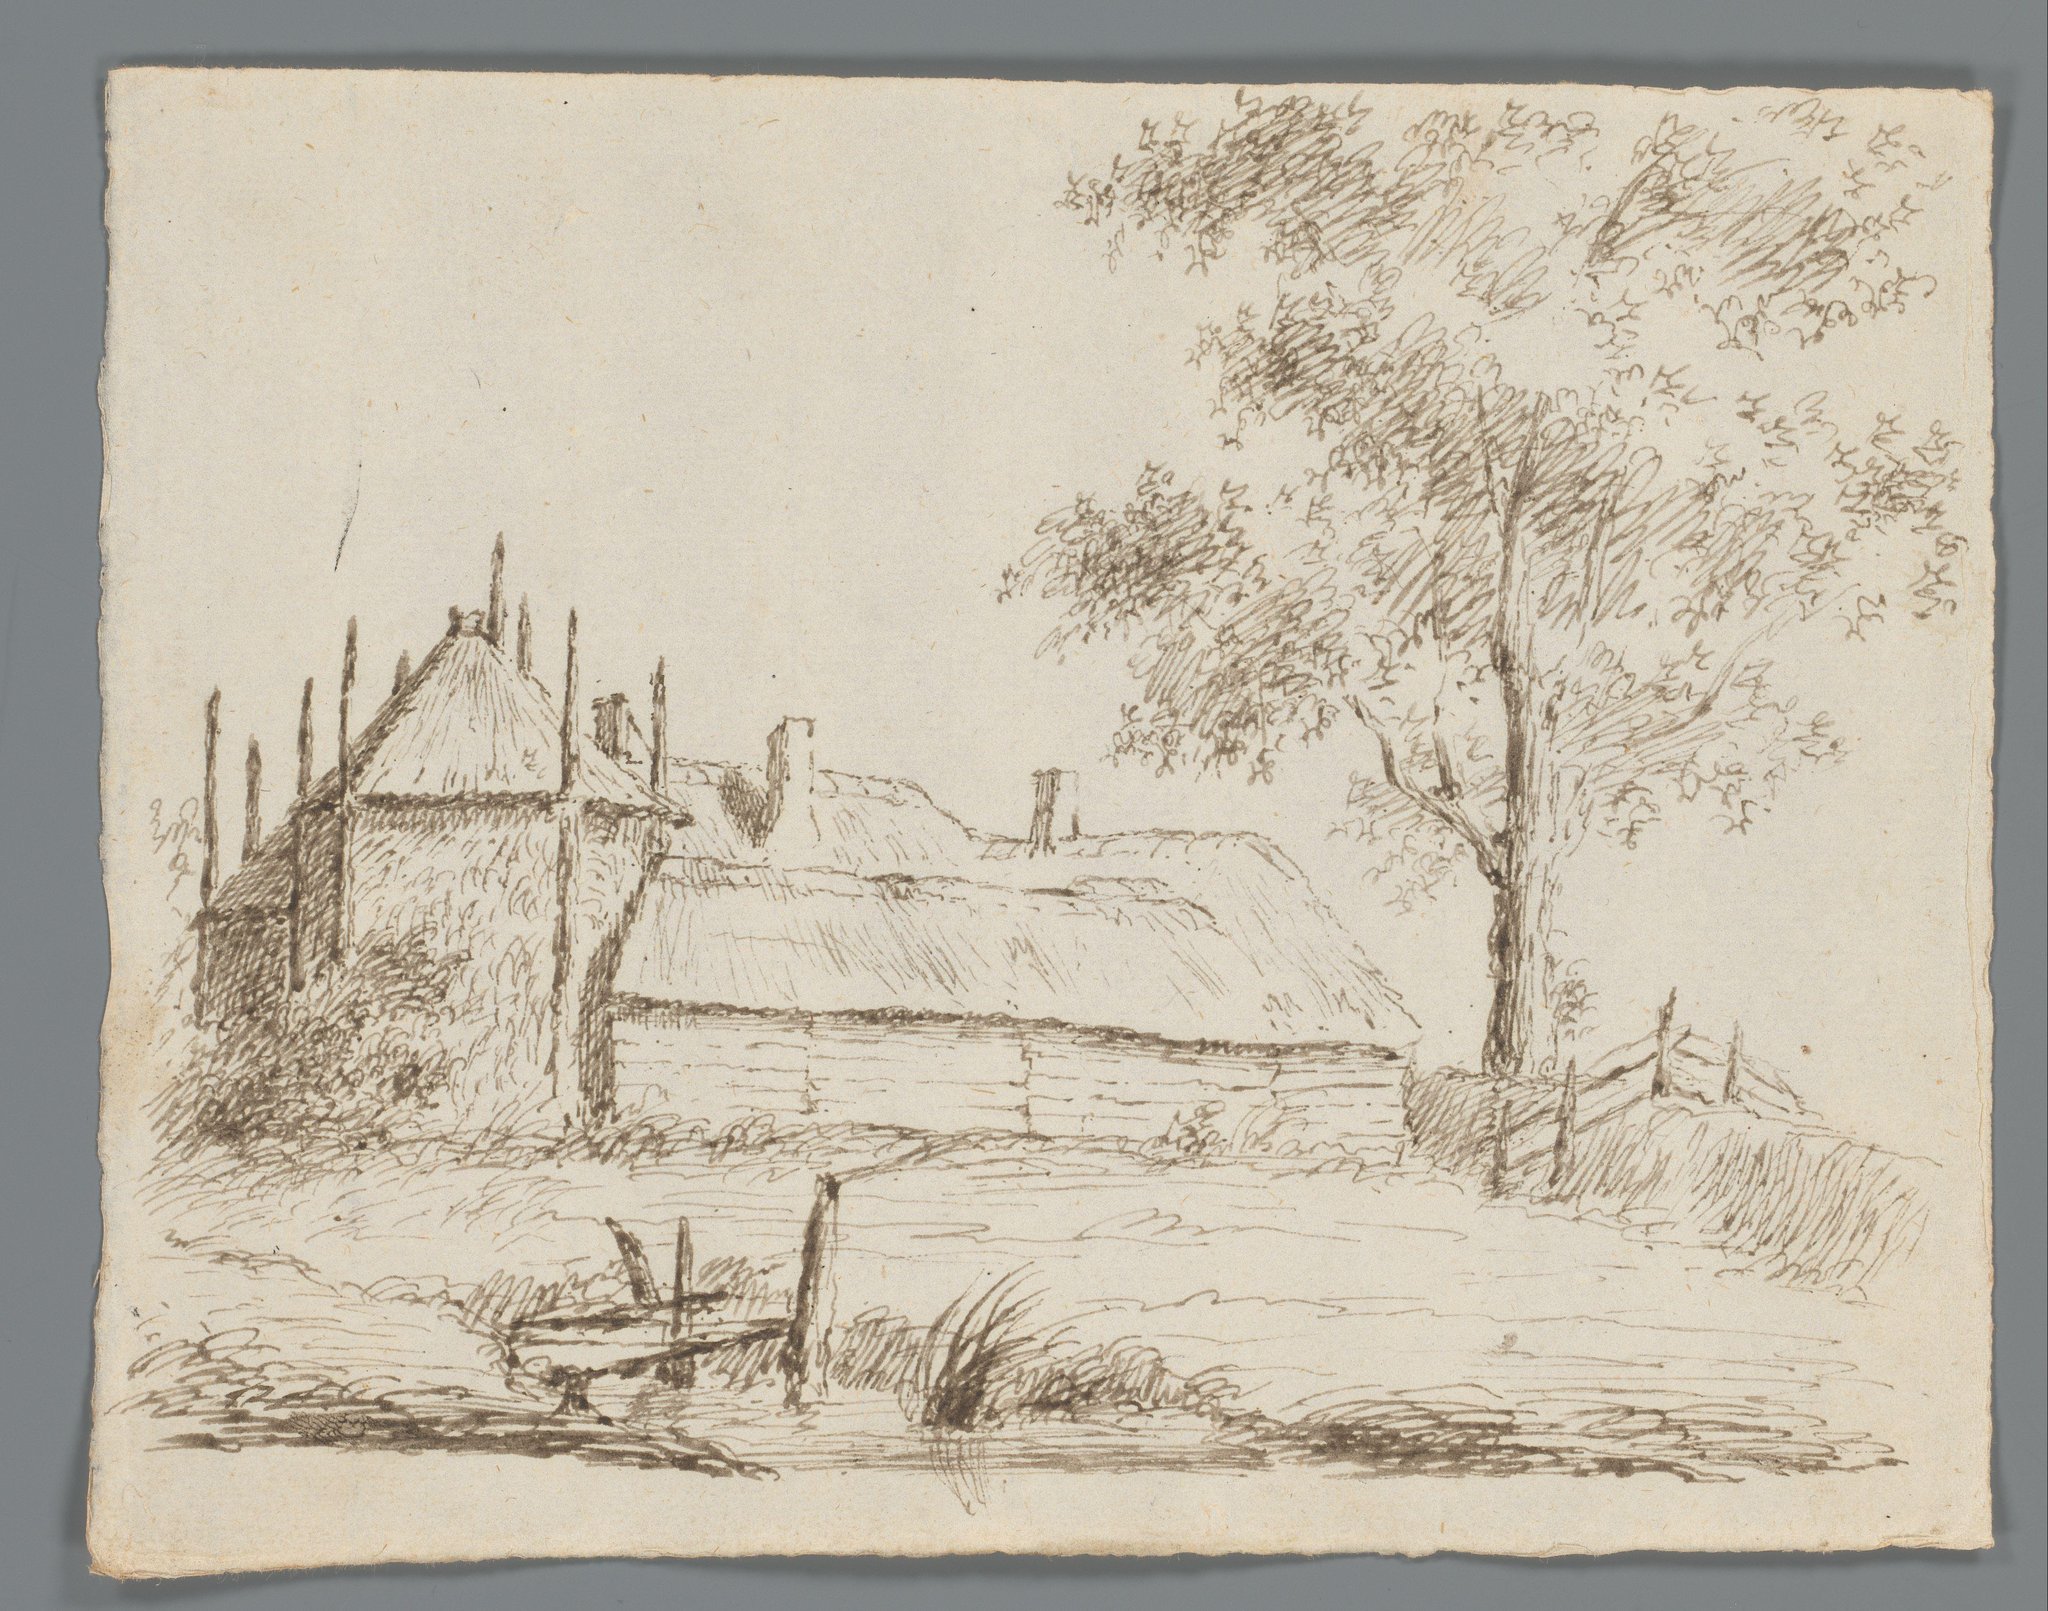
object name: drawing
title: Gezicht op een boerderij met hooischuur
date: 1700-1799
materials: paper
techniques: pen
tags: barn, farm (building)